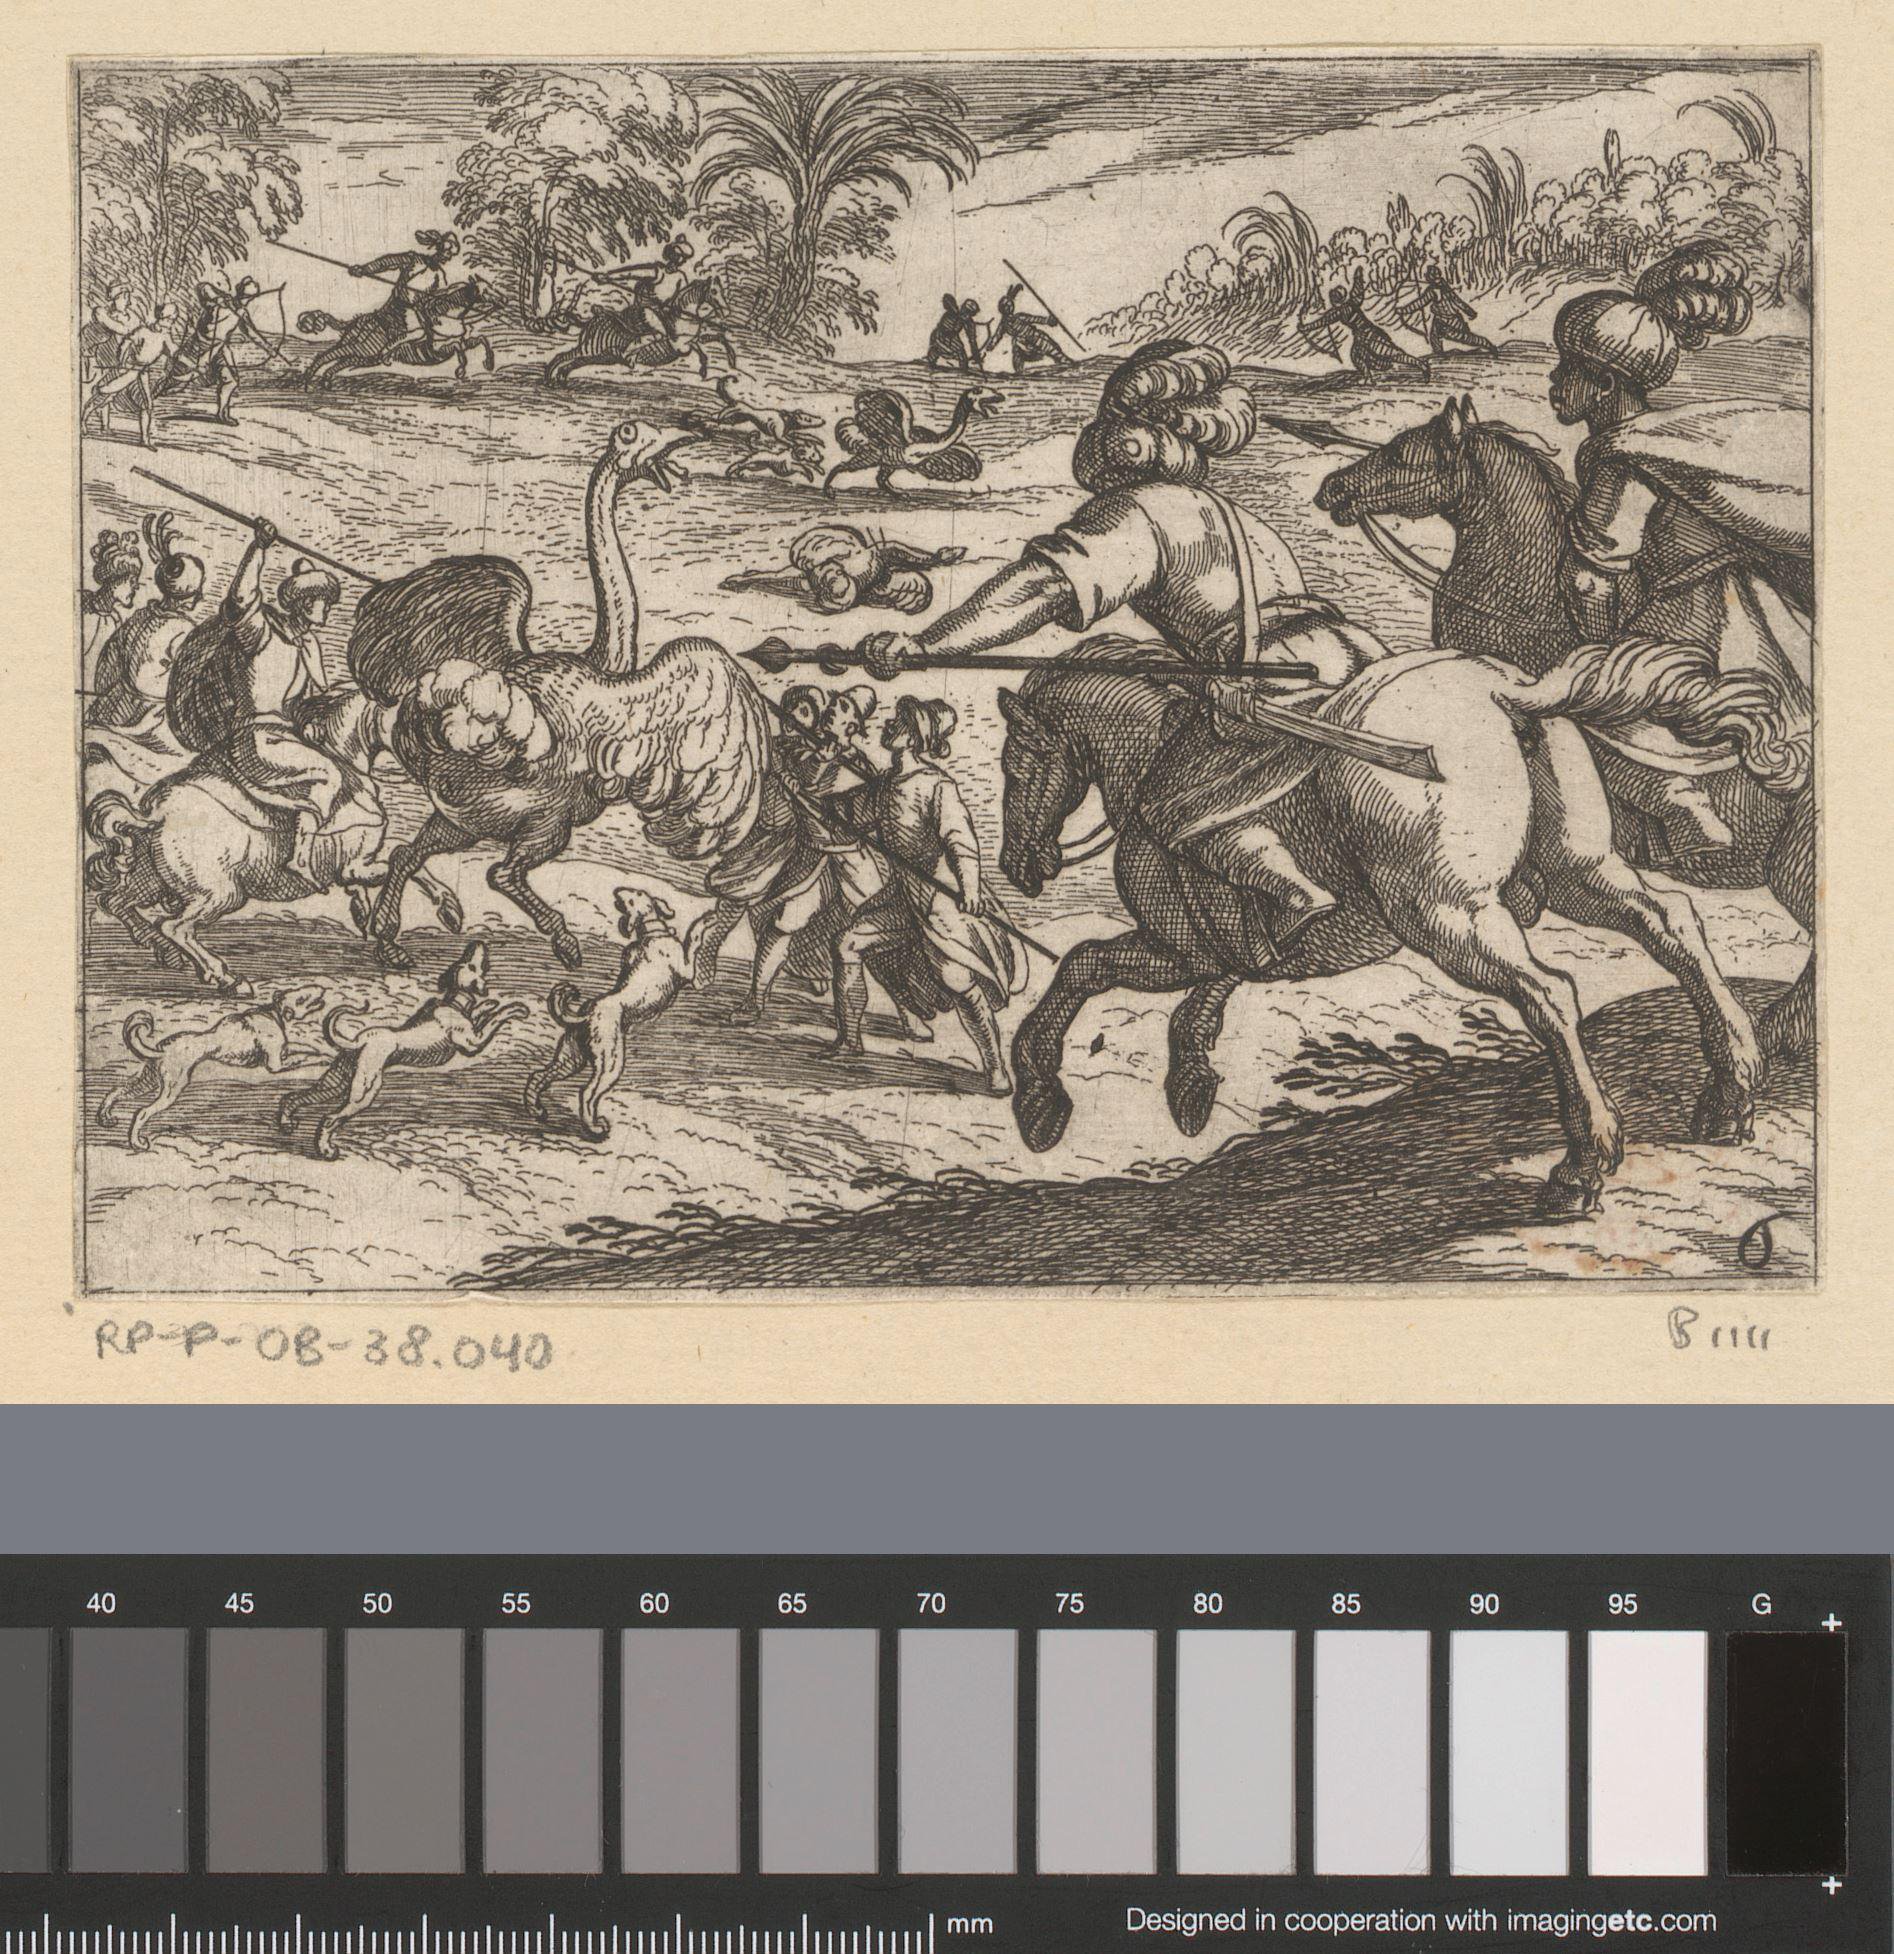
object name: print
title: Jachtscènes (deel 3)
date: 1598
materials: paper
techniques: etching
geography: italy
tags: walker and runner birds: ostrich, hunter, hunters hunting (n.b.: in 1988-1990 this notation denoted the concept of 43c11421 'hunters resting during the hunt'), bird hunting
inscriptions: collector's mark: Lugt 240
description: Deze prent maakt deel uit van een reeks van vijftien prenten met jachtscènes (+ opdracht).